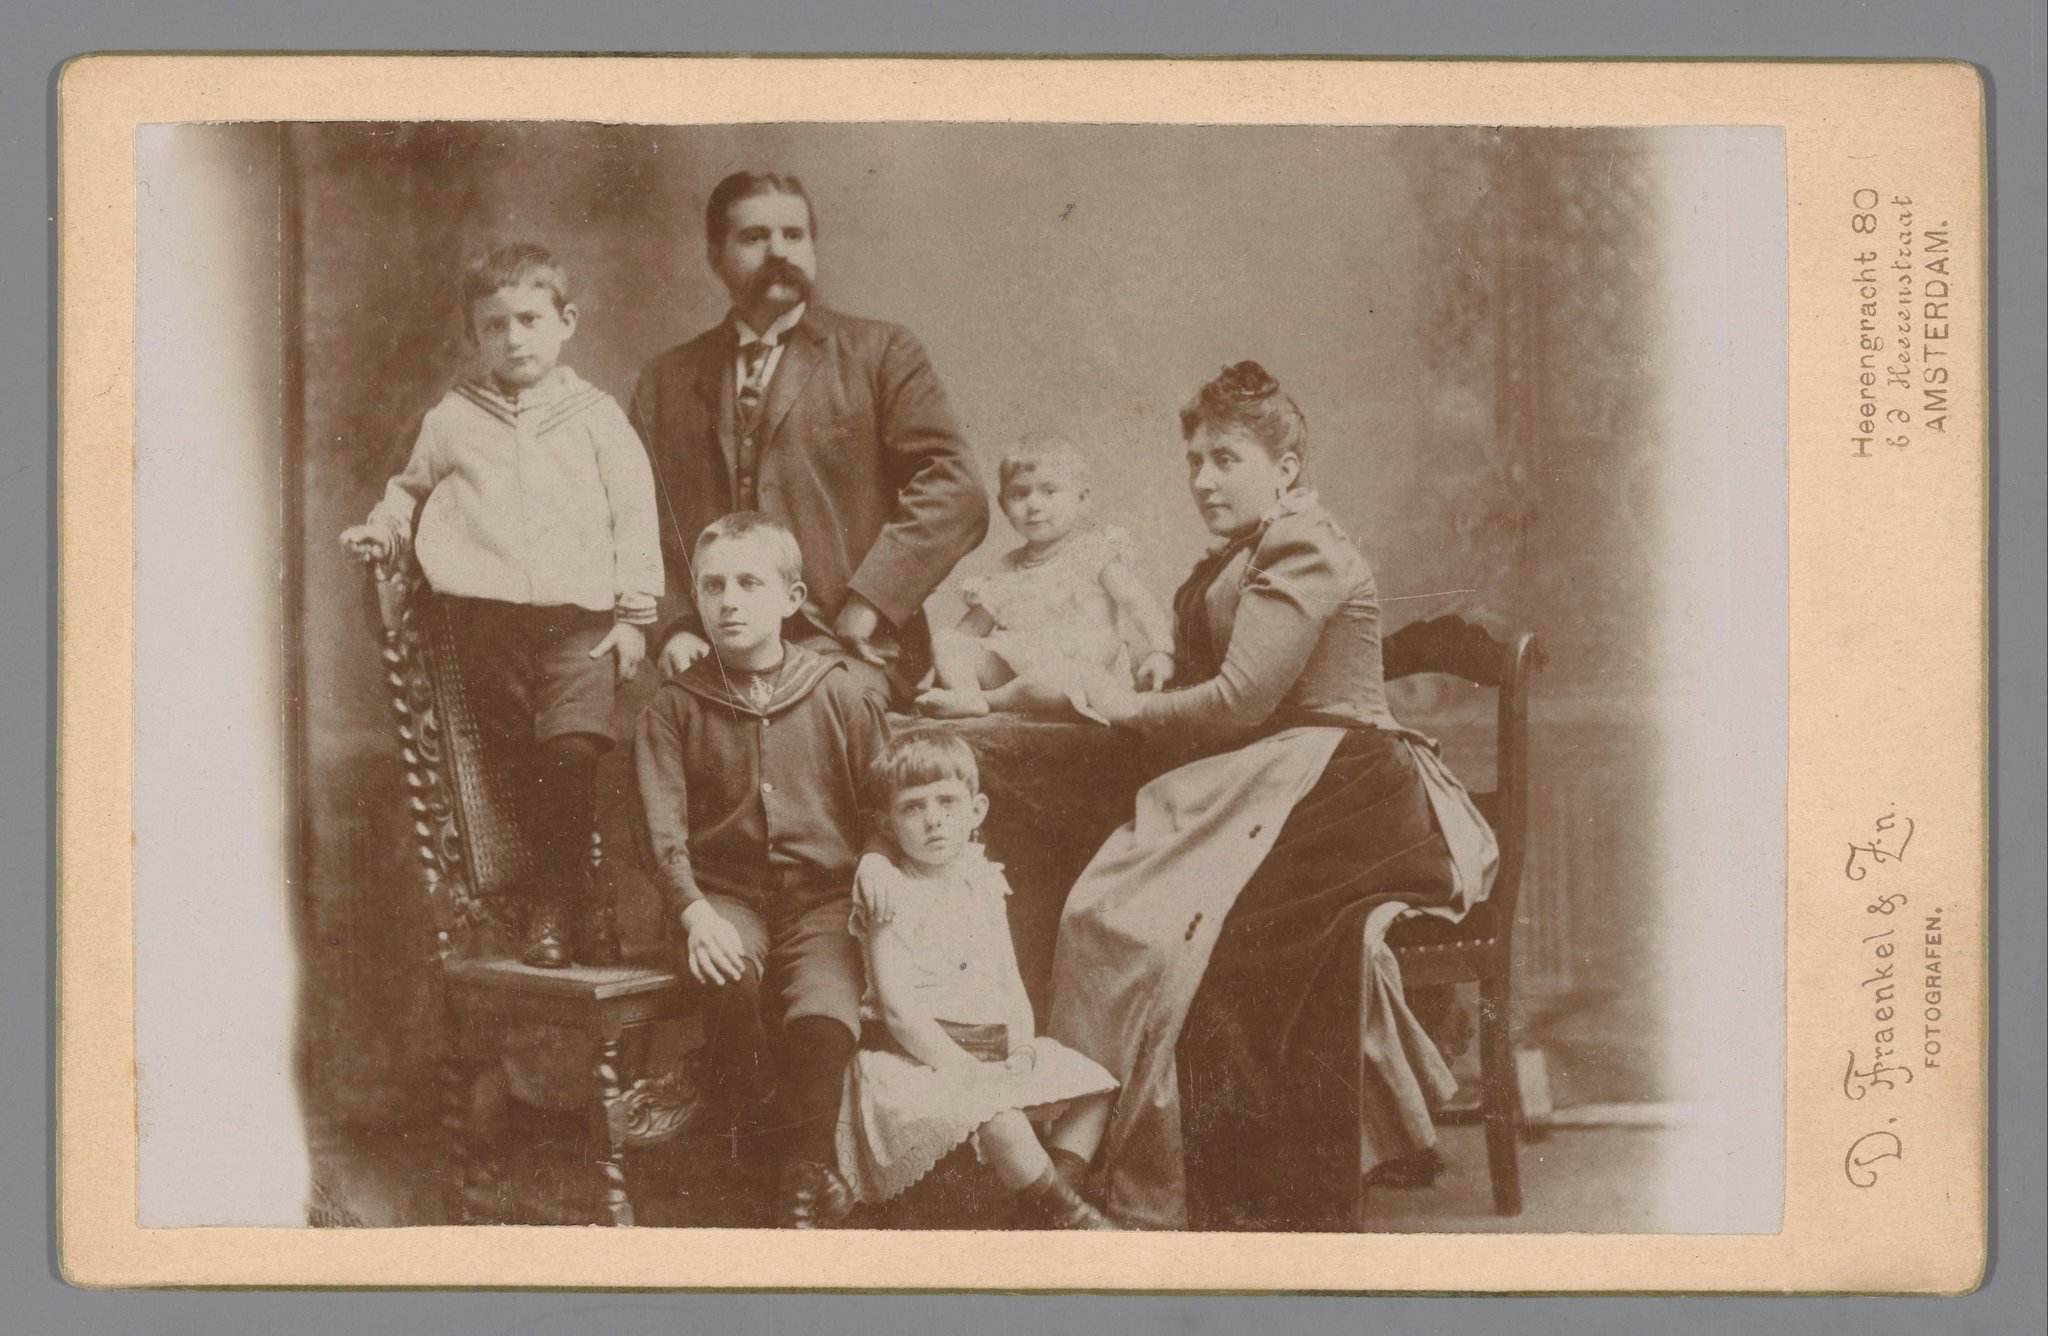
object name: cabinet photograph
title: Groepsportret van vermoedelijk een familie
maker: david fraenkel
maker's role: fotograaf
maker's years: 1845-1930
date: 1903-1906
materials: cardboard, photographic support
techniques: collodion silver print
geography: amsterdam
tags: family, descendance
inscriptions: name: ‘D. Fraenkel & Zn. Fotografen. Heerengracht 80 bd Heerenstraat Amsterdam.’